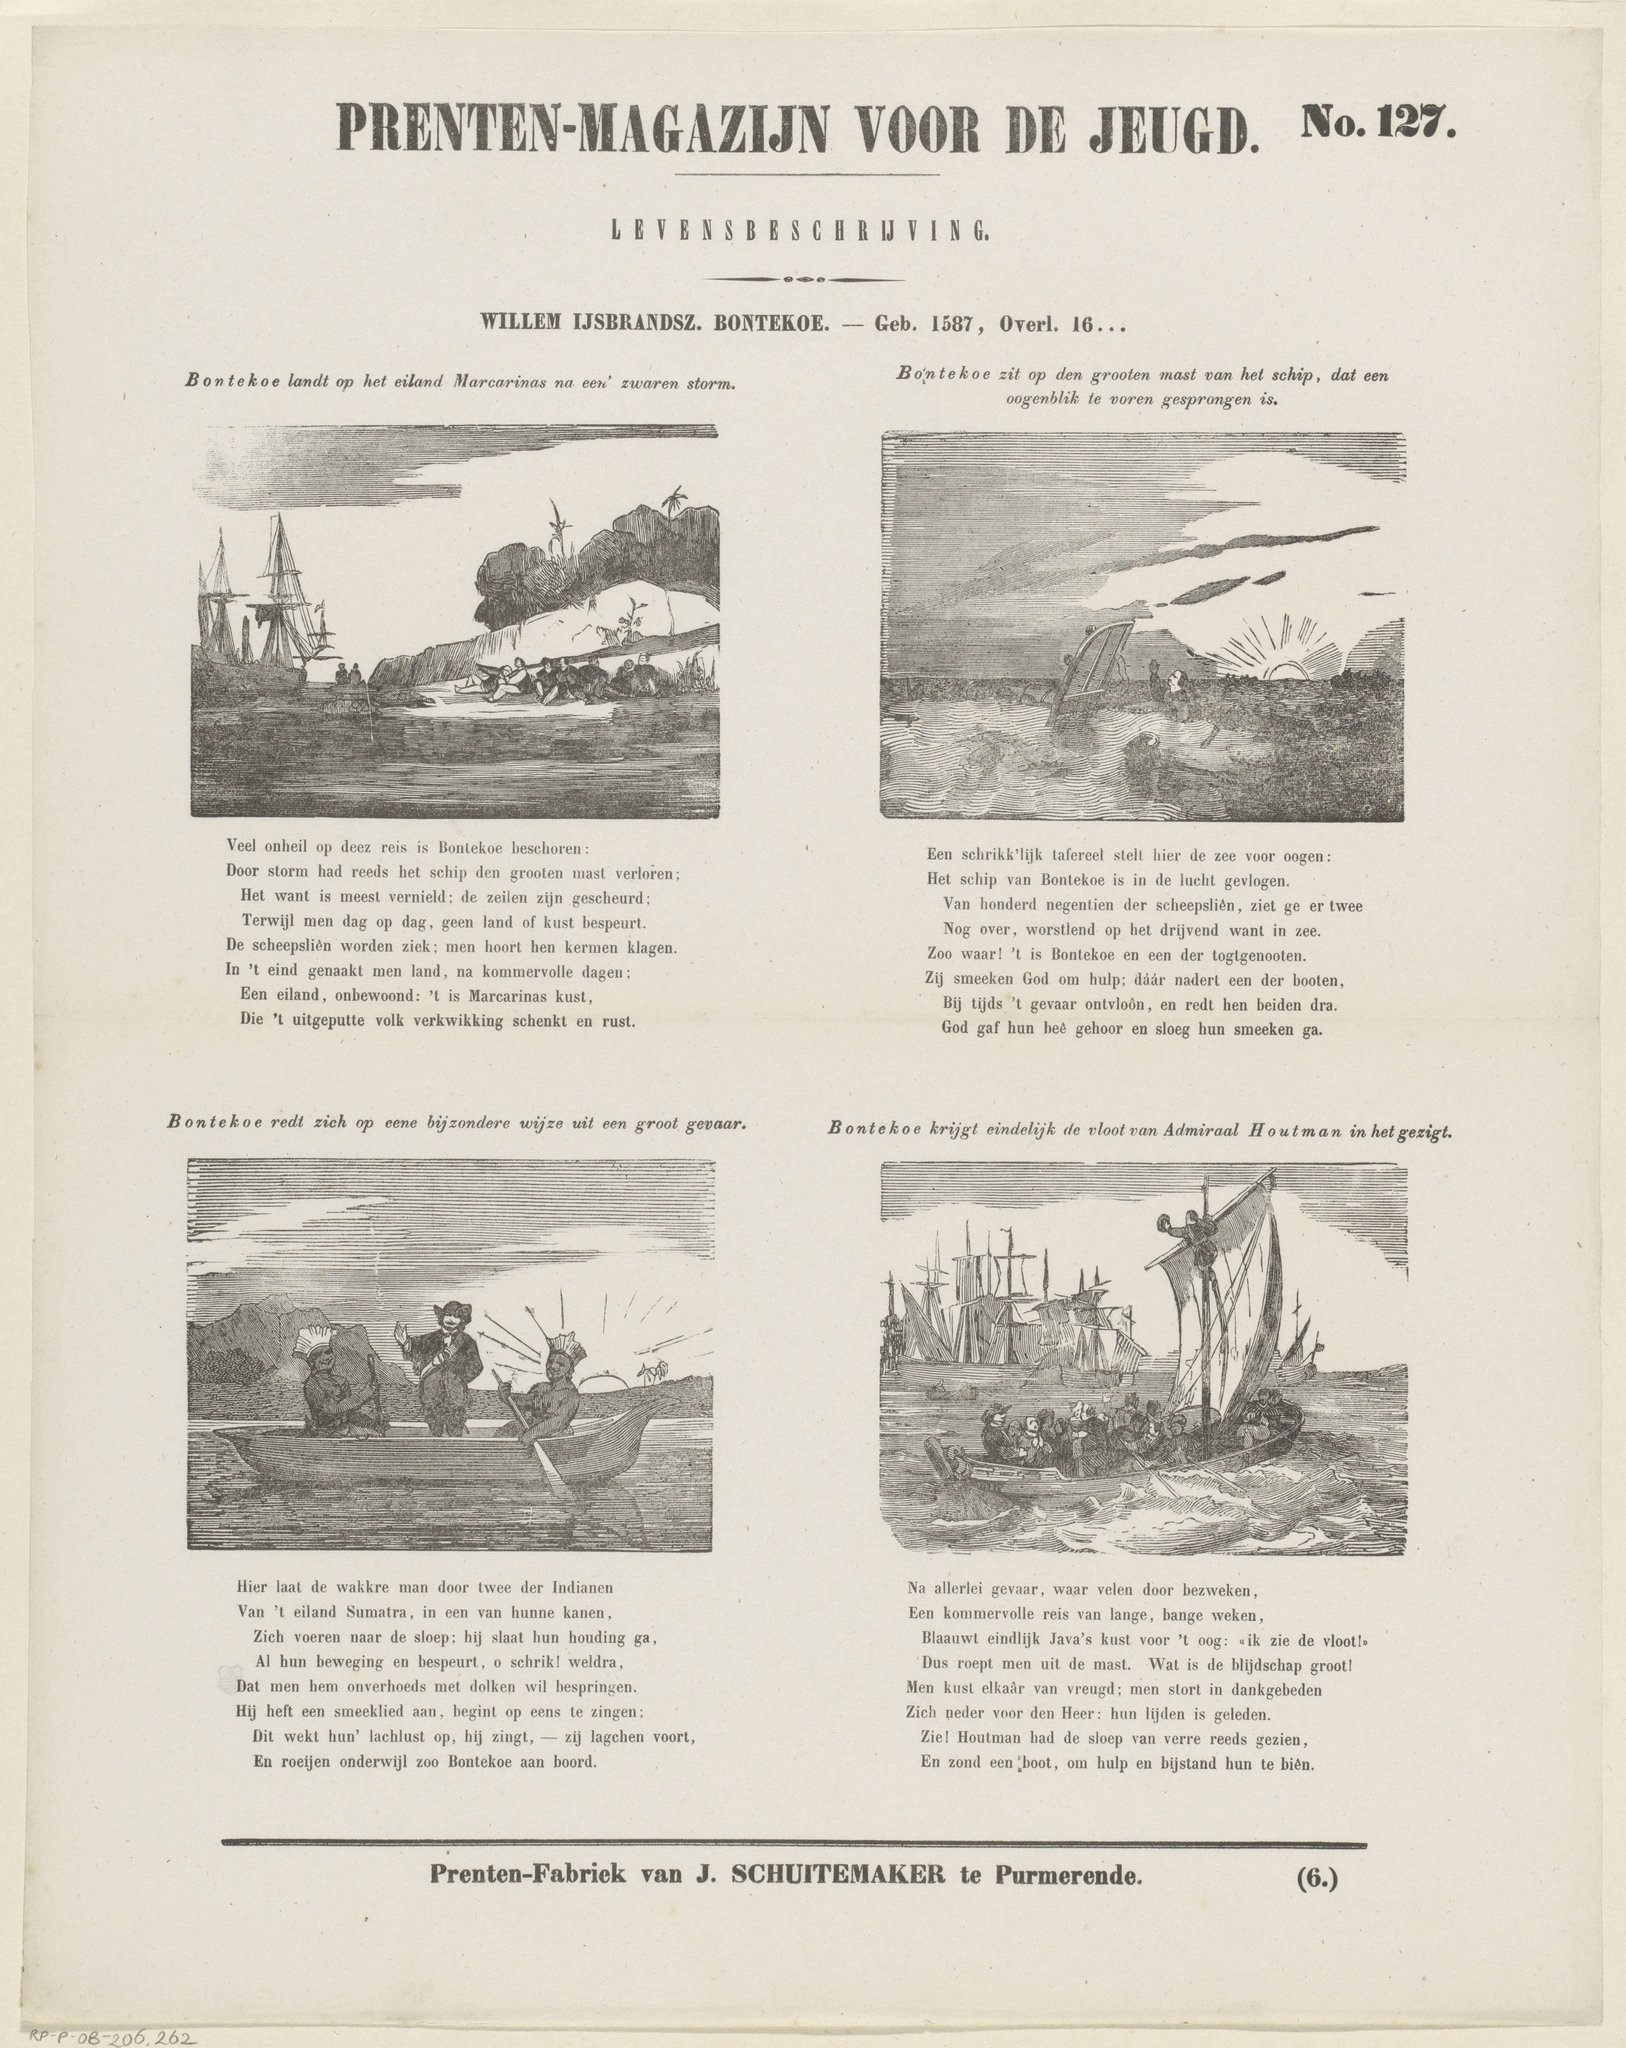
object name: popular print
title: Willem IJsbrandsz. Bontekoe. - Geb. 1587, Overl. 16 (...)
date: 1850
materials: paper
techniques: letterpress printing, engraving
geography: purmerend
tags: hoorn (north holland), willem ysbrantsz. bontekoe, historical persons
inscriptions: collector's mark: Lugt 2760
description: Na voltooiing van de acht jaargangen van de reeks 'Prenten-magazijn voor de jeugd' in 1850 heeft Jan Schuitemaker al deze prenten heruitgegeven en omgenummerd als nr. 1 t/m 192. De oorspronkelijke jaargang wordt telkens nog vermeld rechtsonder op de prent. Binnen de jaargangen zijn prenten van hetzelfde thema in clusters van vier achter elkaar gezet.